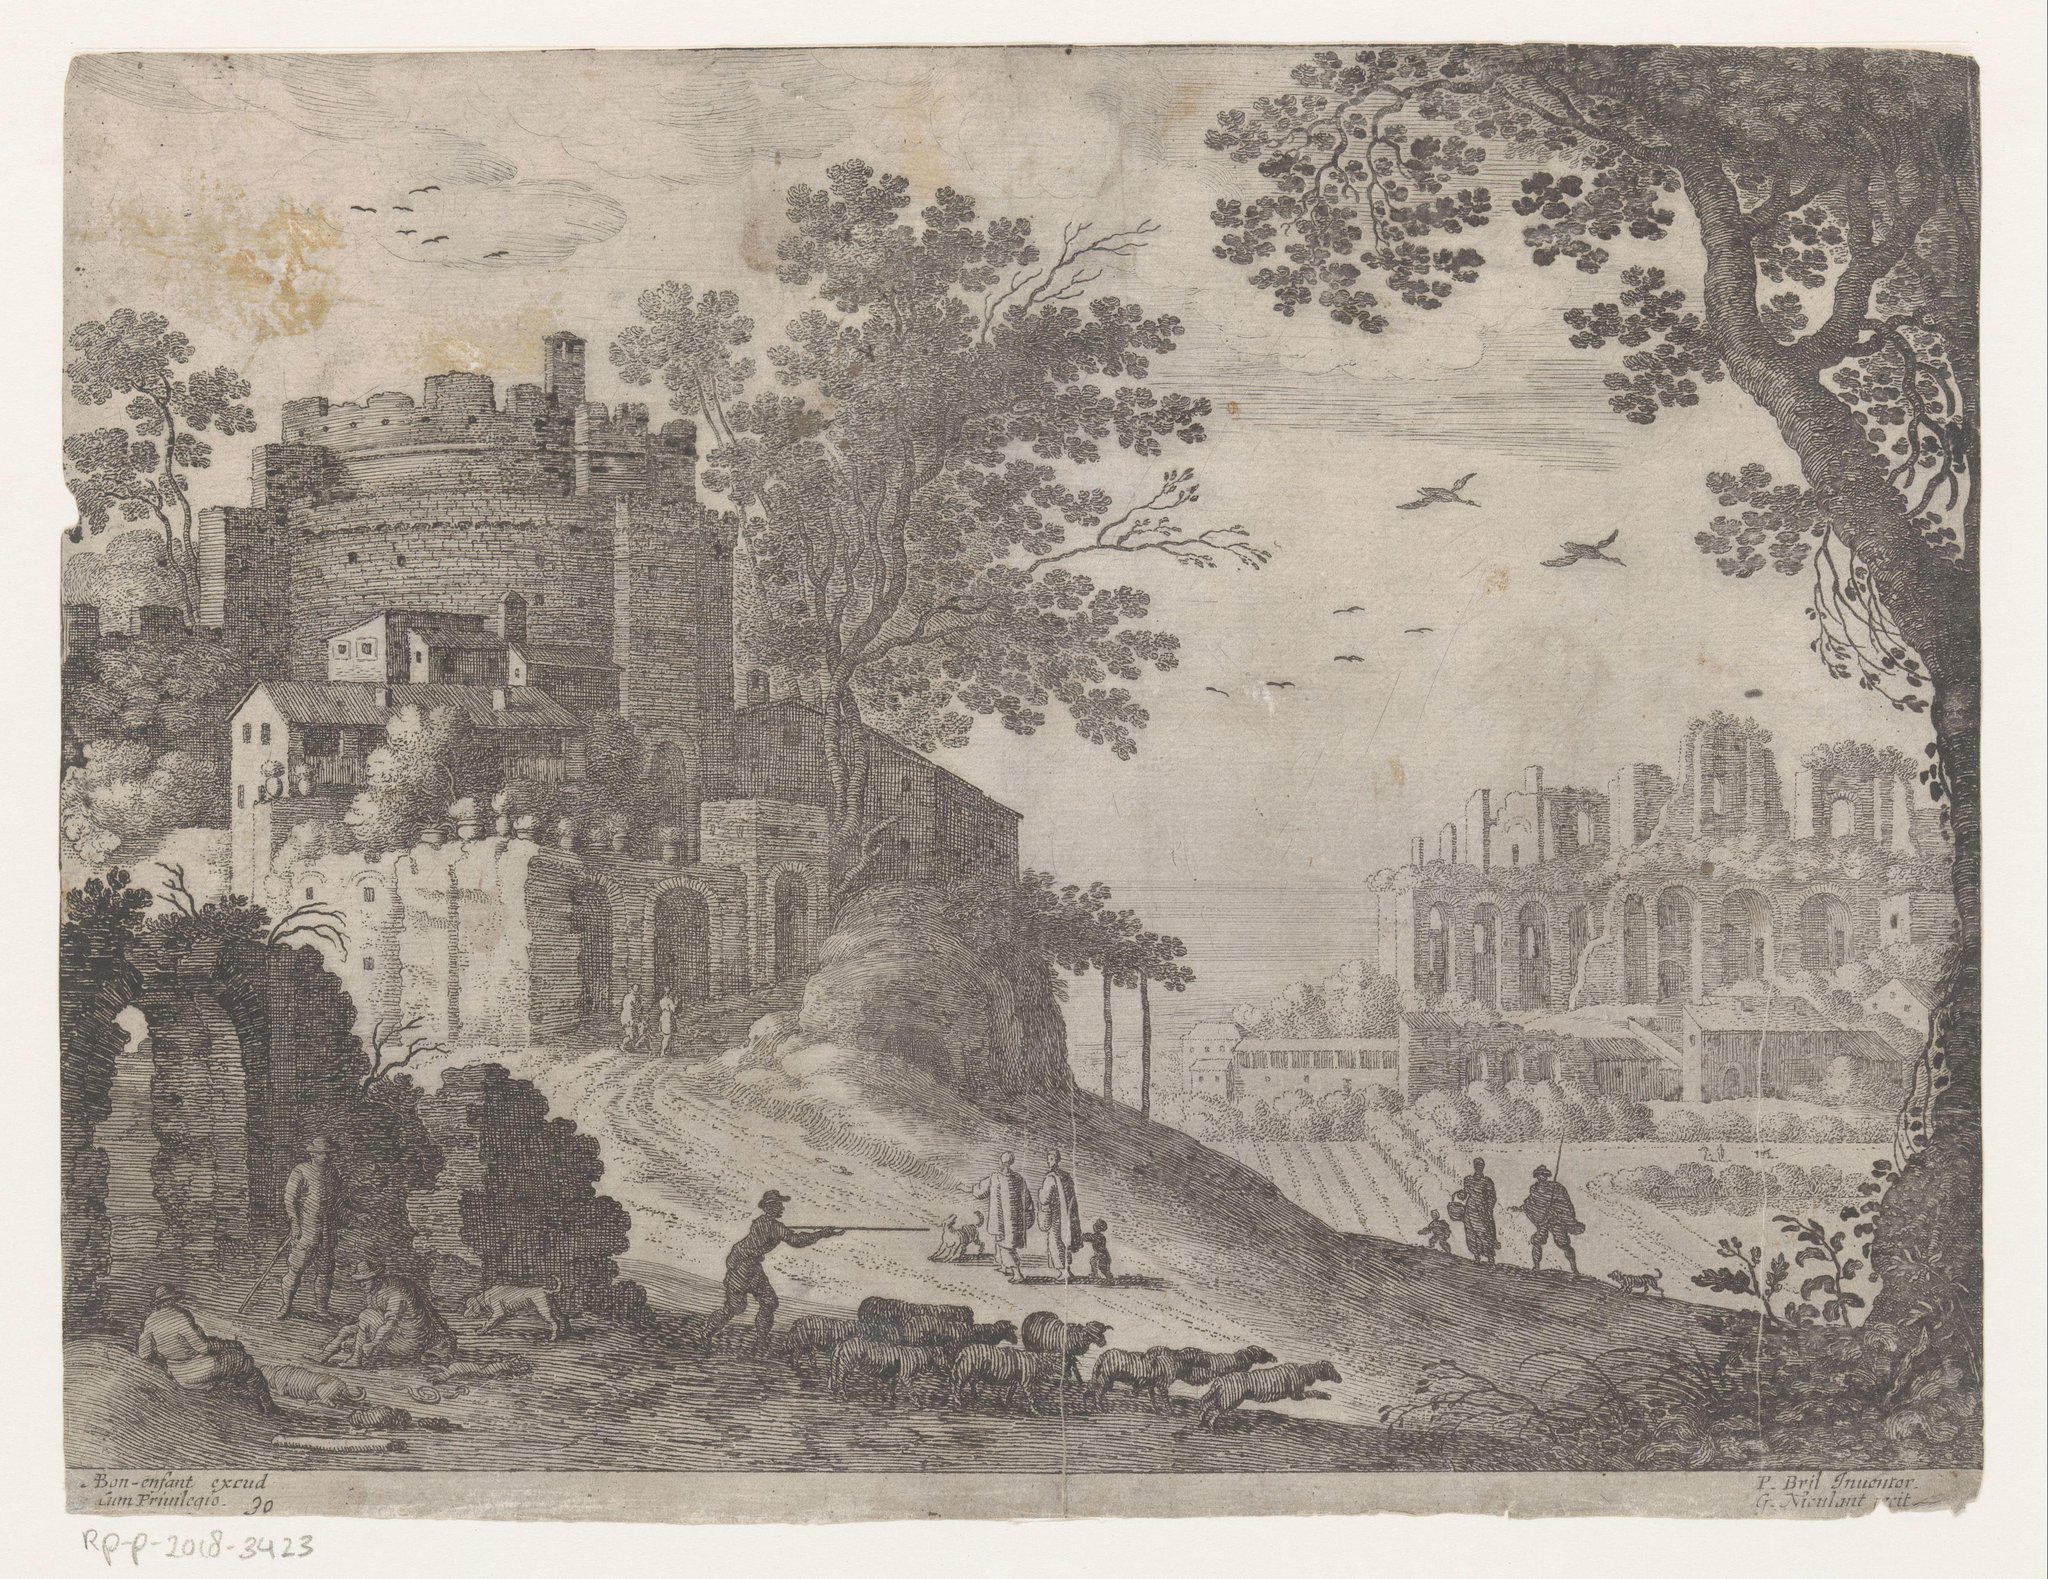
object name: print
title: Italiaanse landschappen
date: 1594-1626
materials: paper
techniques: engraving, etching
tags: herding, herdsman, herdswoman, shepherd, shepherdess, cowherd, etc., landscape with ruins, dog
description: In een Italiaans landschap liggen verschillende gebouwen aan de weg. In de achtergrond ligt een ruïne. Op de voorgrond een herder met zijn kudde schapen en mannen met honden voor een poort. Linksonder genummerd: 30.